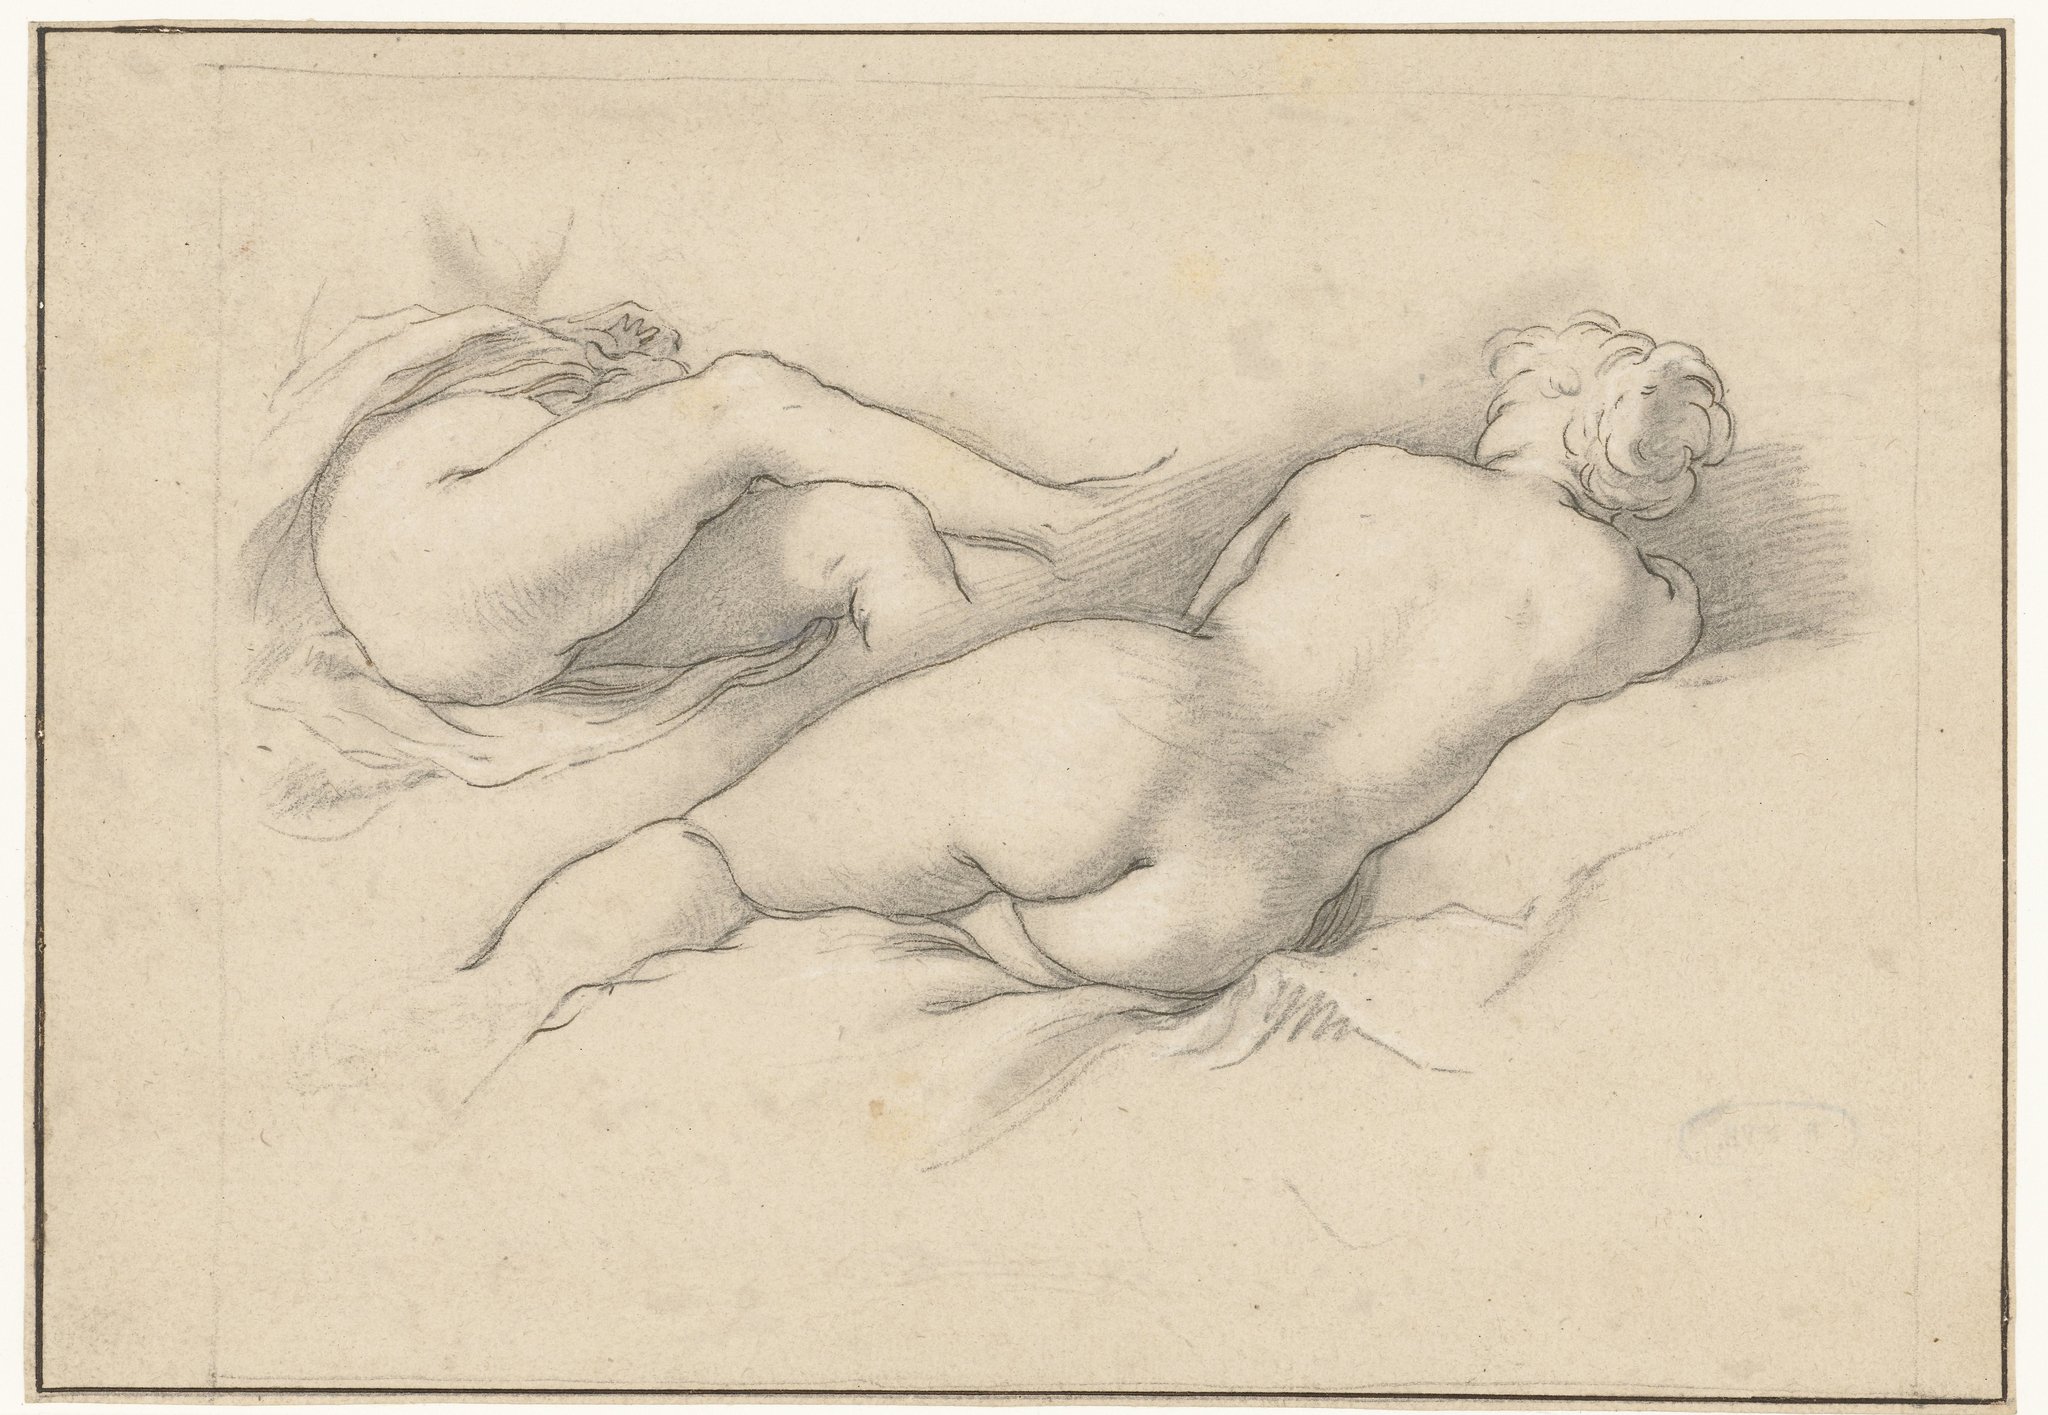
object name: drawing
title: Studies of a Reclining Female Nude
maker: abraham bloemaert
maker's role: draughtsman, painter, print maker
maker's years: 1566-1651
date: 1645-1651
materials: chalk, ink, paint, paper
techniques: pen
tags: lying figure - aa - female human figure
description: In the course of his exceptionally long life – he lived to be over 80 – Bloemaert made hundreds of drawings. He drew from his own imagination, after life models, and after the nature near his place of residence, Utrecht. He often copied and reused motifs in his drawings. These studies of nudes also feature in a drawing that Bloemaert had made more than 40 years earlier.